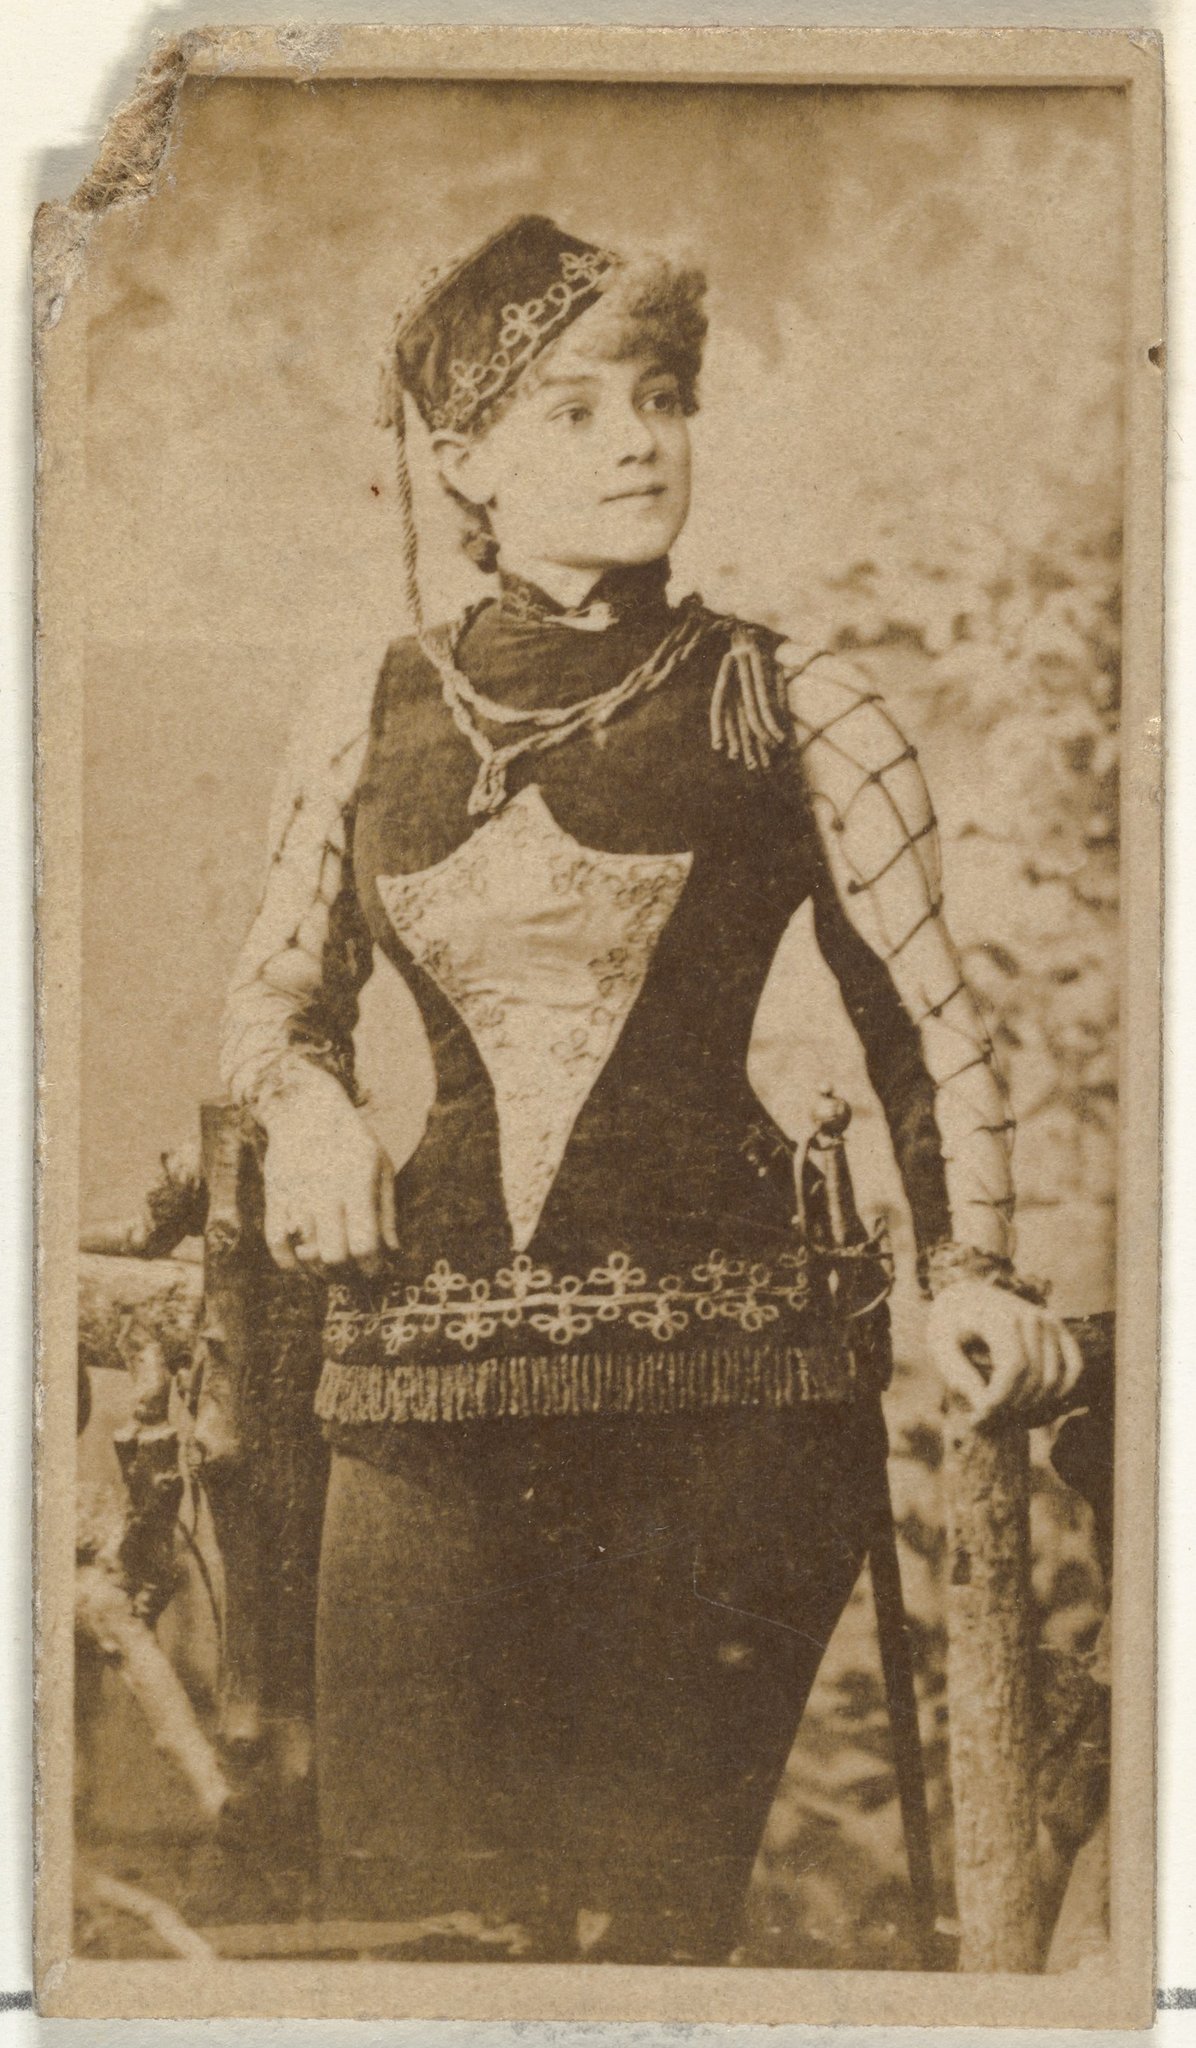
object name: photograph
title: [Actress wearing fez], from the Actors and Actresses series (N145-8) issued by Duke Sons & Co. to promote Duke Cigarettes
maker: w. duke, sons & co.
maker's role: publisher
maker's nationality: american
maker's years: 1870-1920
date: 1891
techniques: albumen silver print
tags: portraits,women,actresses